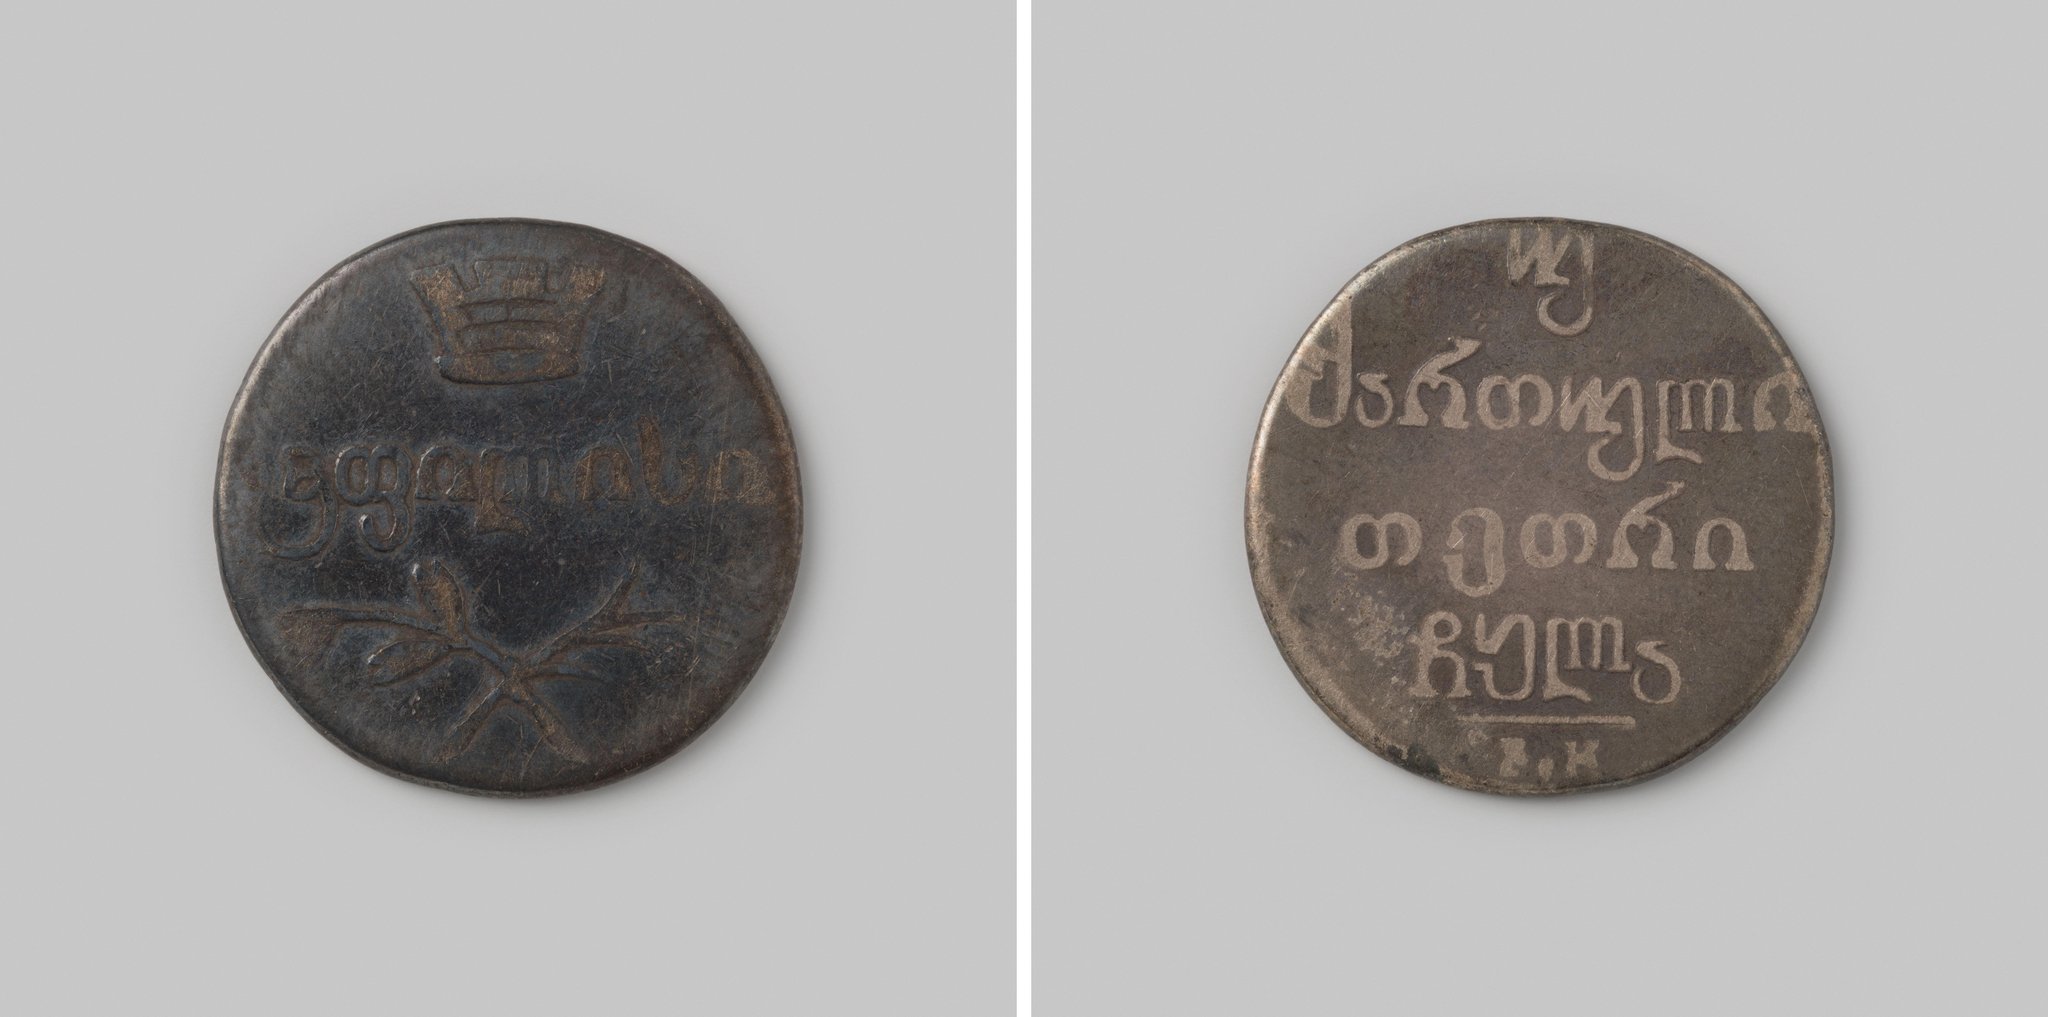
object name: coin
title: Georgië, tsaar Nikolai I, dubble abazi of 40 kopeken, 1831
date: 1831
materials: silver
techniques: striking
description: Zilveren munt. Voorzijde: aanduiding in Georgisch schrfit. Daarboven een kroon en daaronder twee gekruiste takken. Keerzijde: in drie regels de waarde-aanduiding in Georgisch schrift, waaronder jaartal in het Georgisch. Kabelrand.